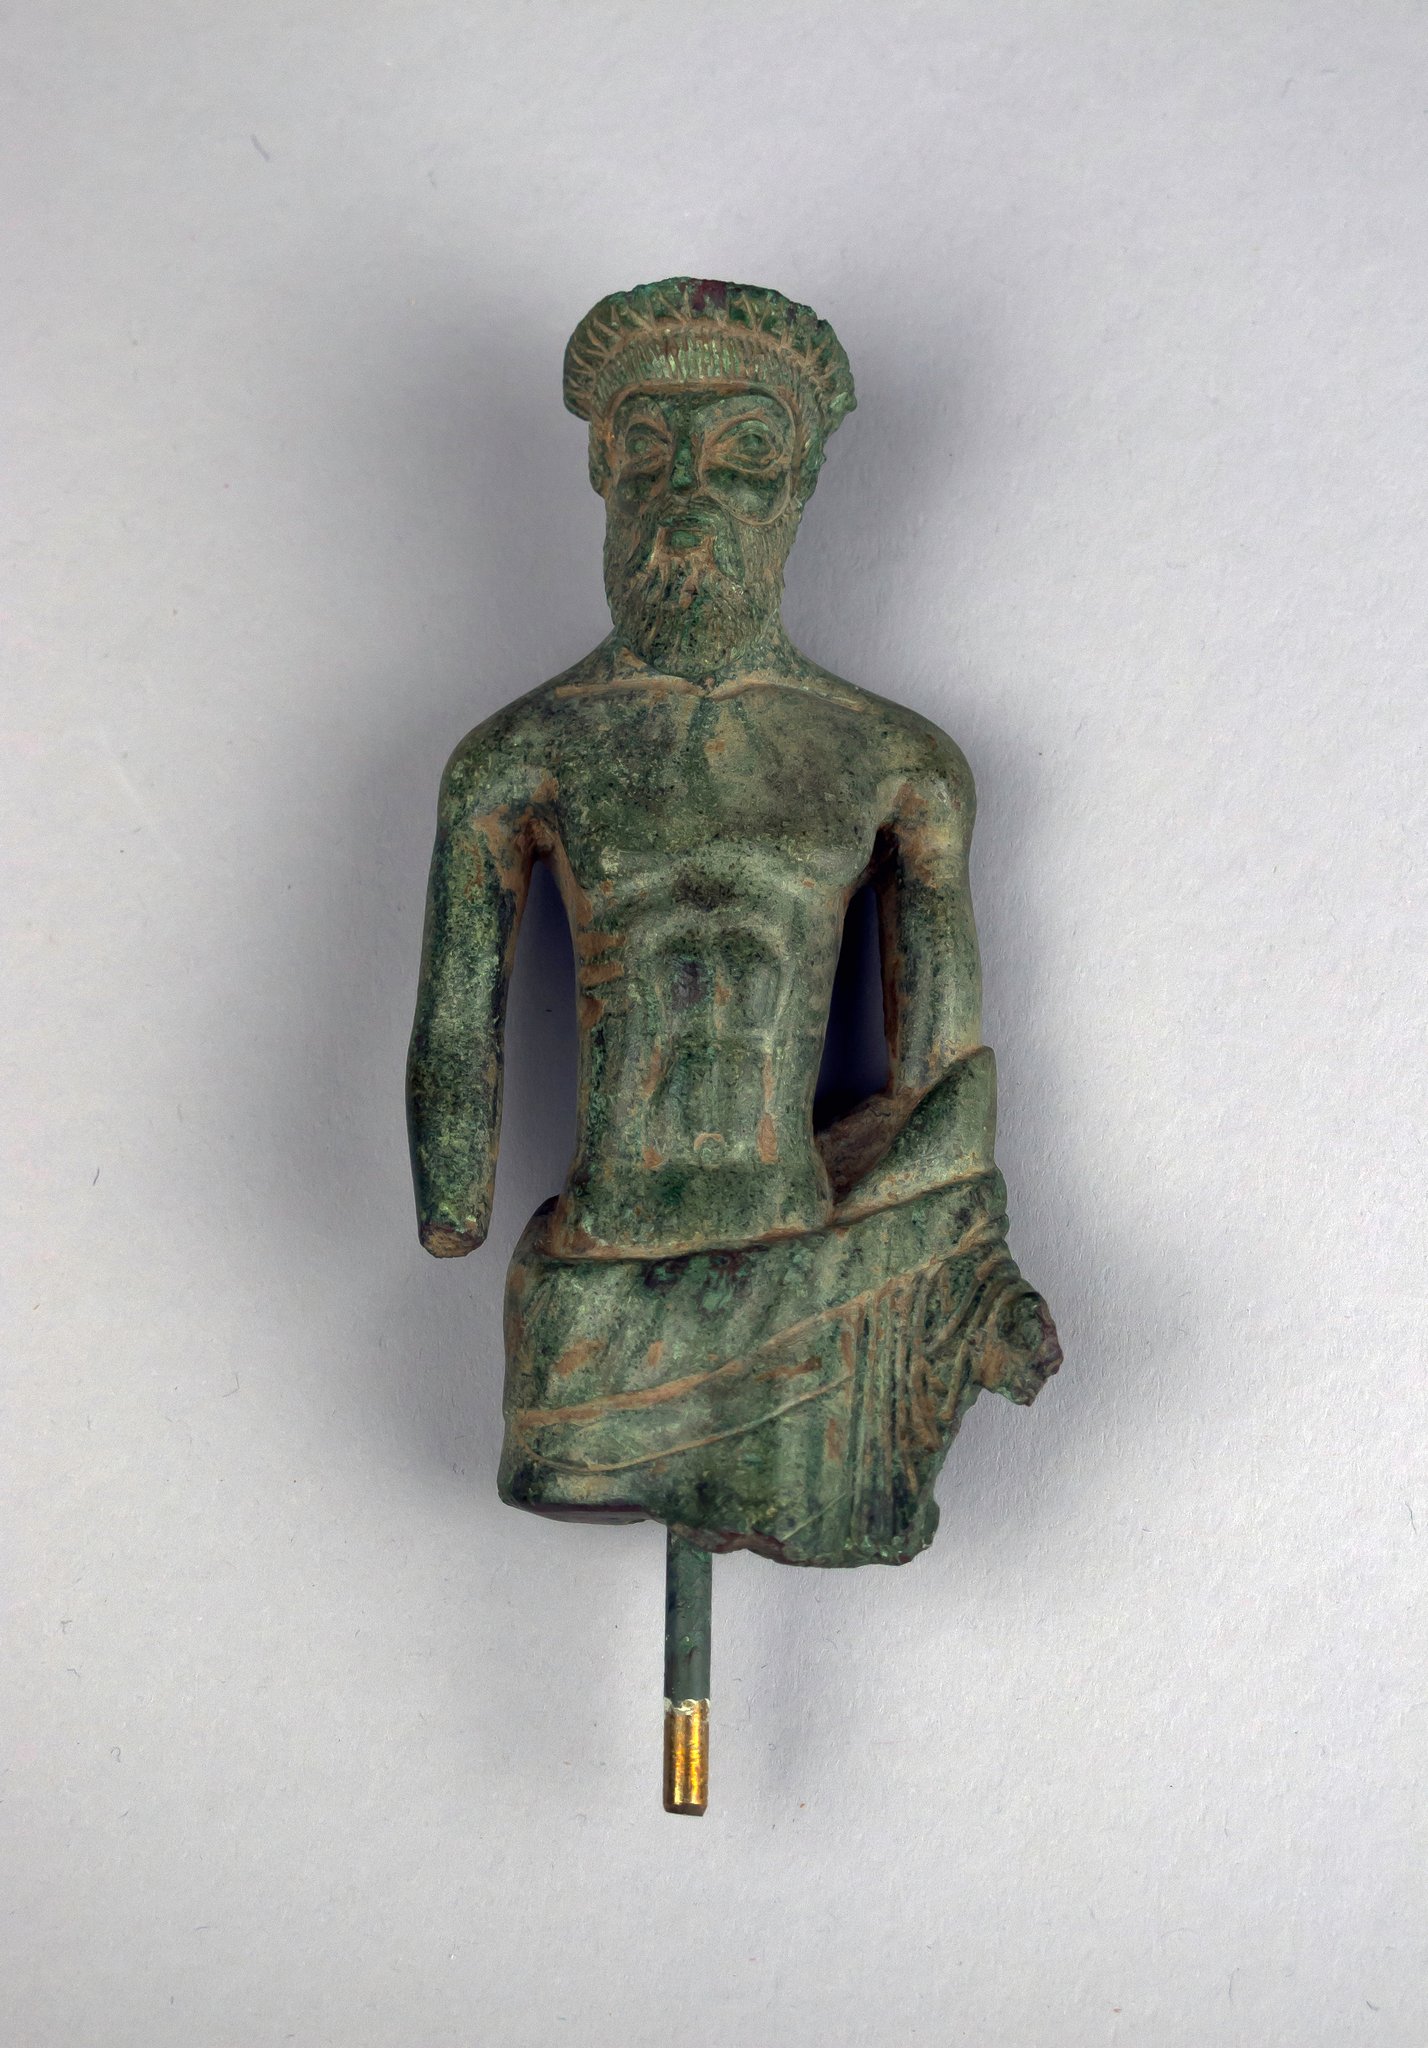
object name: statuette of a man, upper half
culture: etruscan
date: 900-100 BCE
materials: bronze